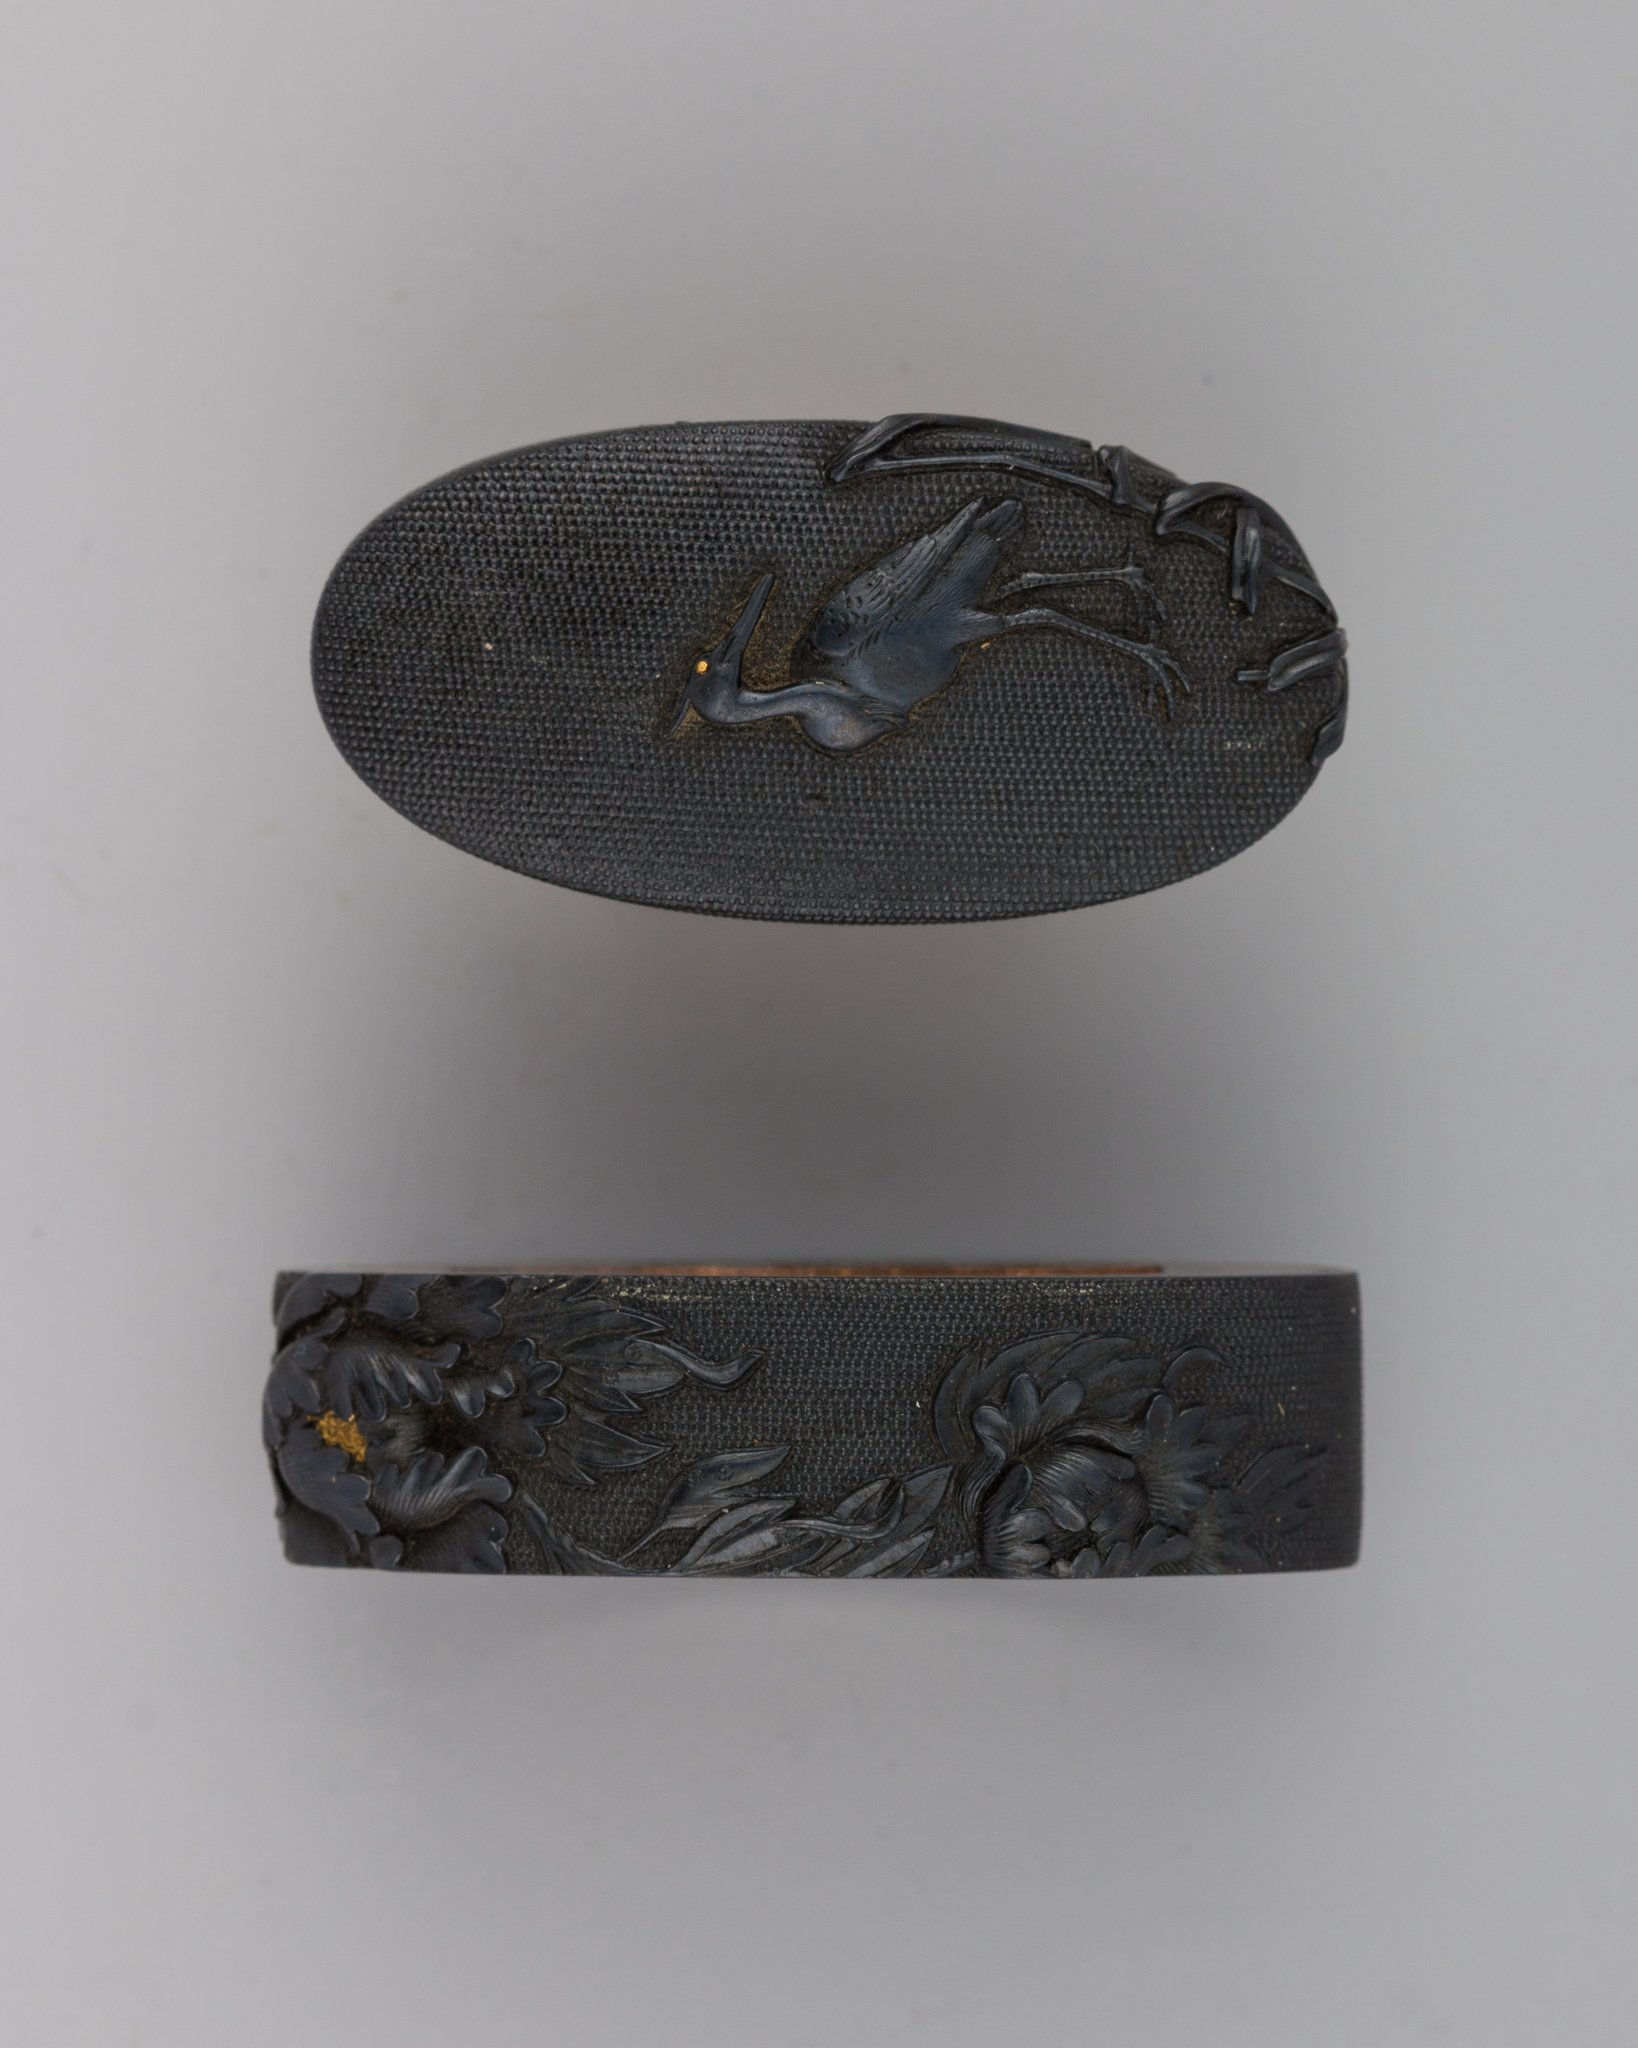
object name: sword hilt collar and pommel fuchigashira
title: Sword-Hilt Collar and Pommel (Fuchigashira)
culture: japanese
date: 1615-1868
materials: gold alloy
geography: japan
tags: birds